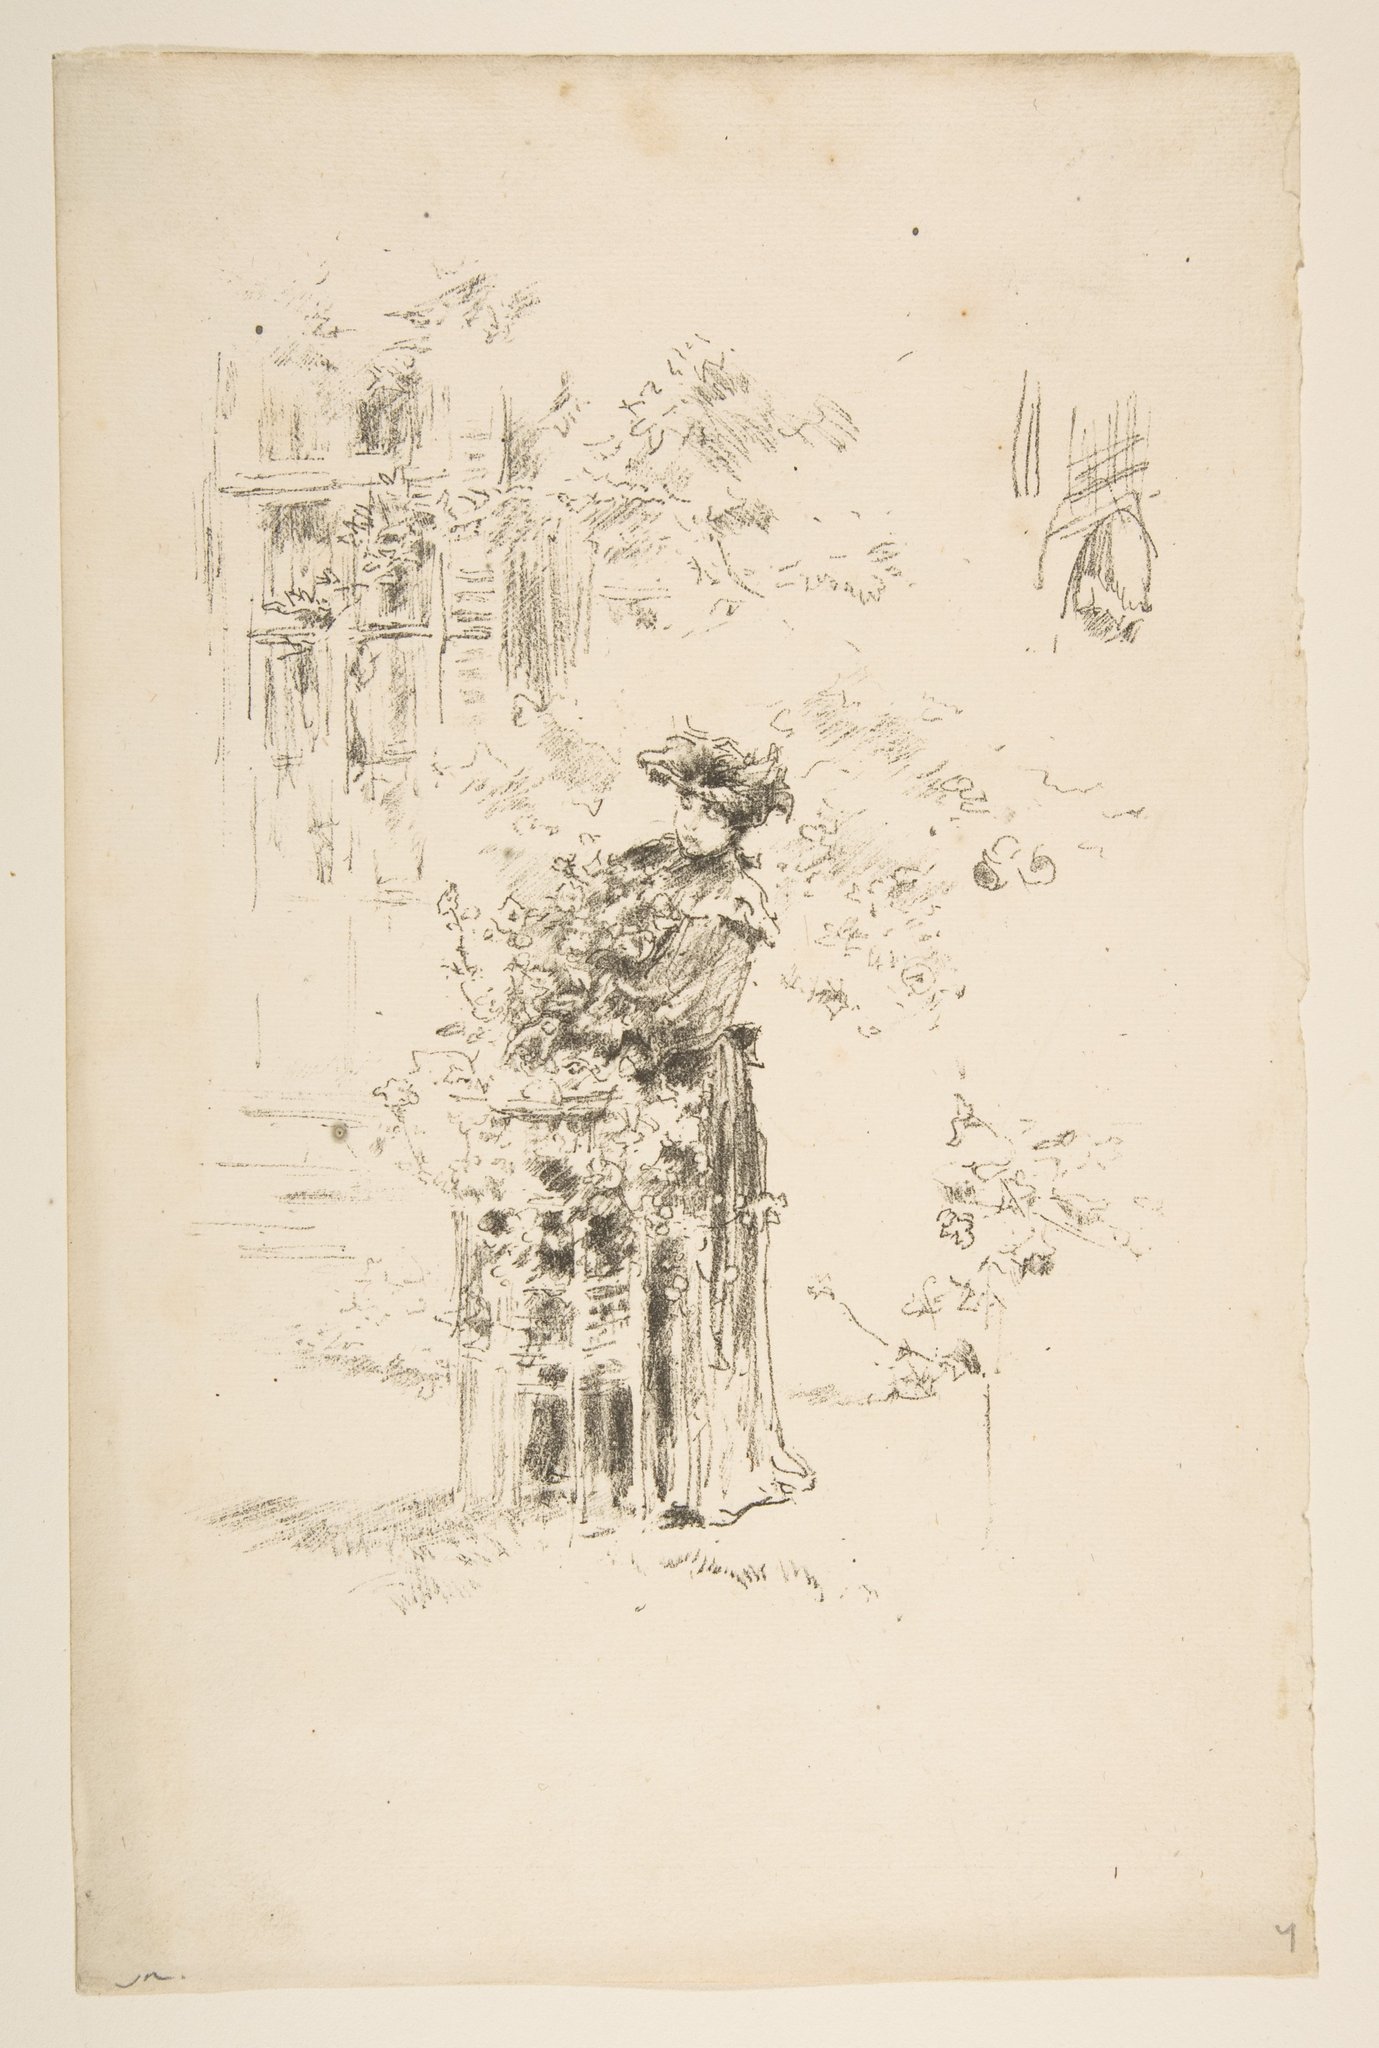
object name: print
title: La Belle Jardinière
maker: james mcneill whistler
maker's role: artist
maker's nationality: american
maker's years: 1834-1903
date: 1894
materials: ink, paper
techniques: printing, scraping, stumping, lithography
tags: women,flowers